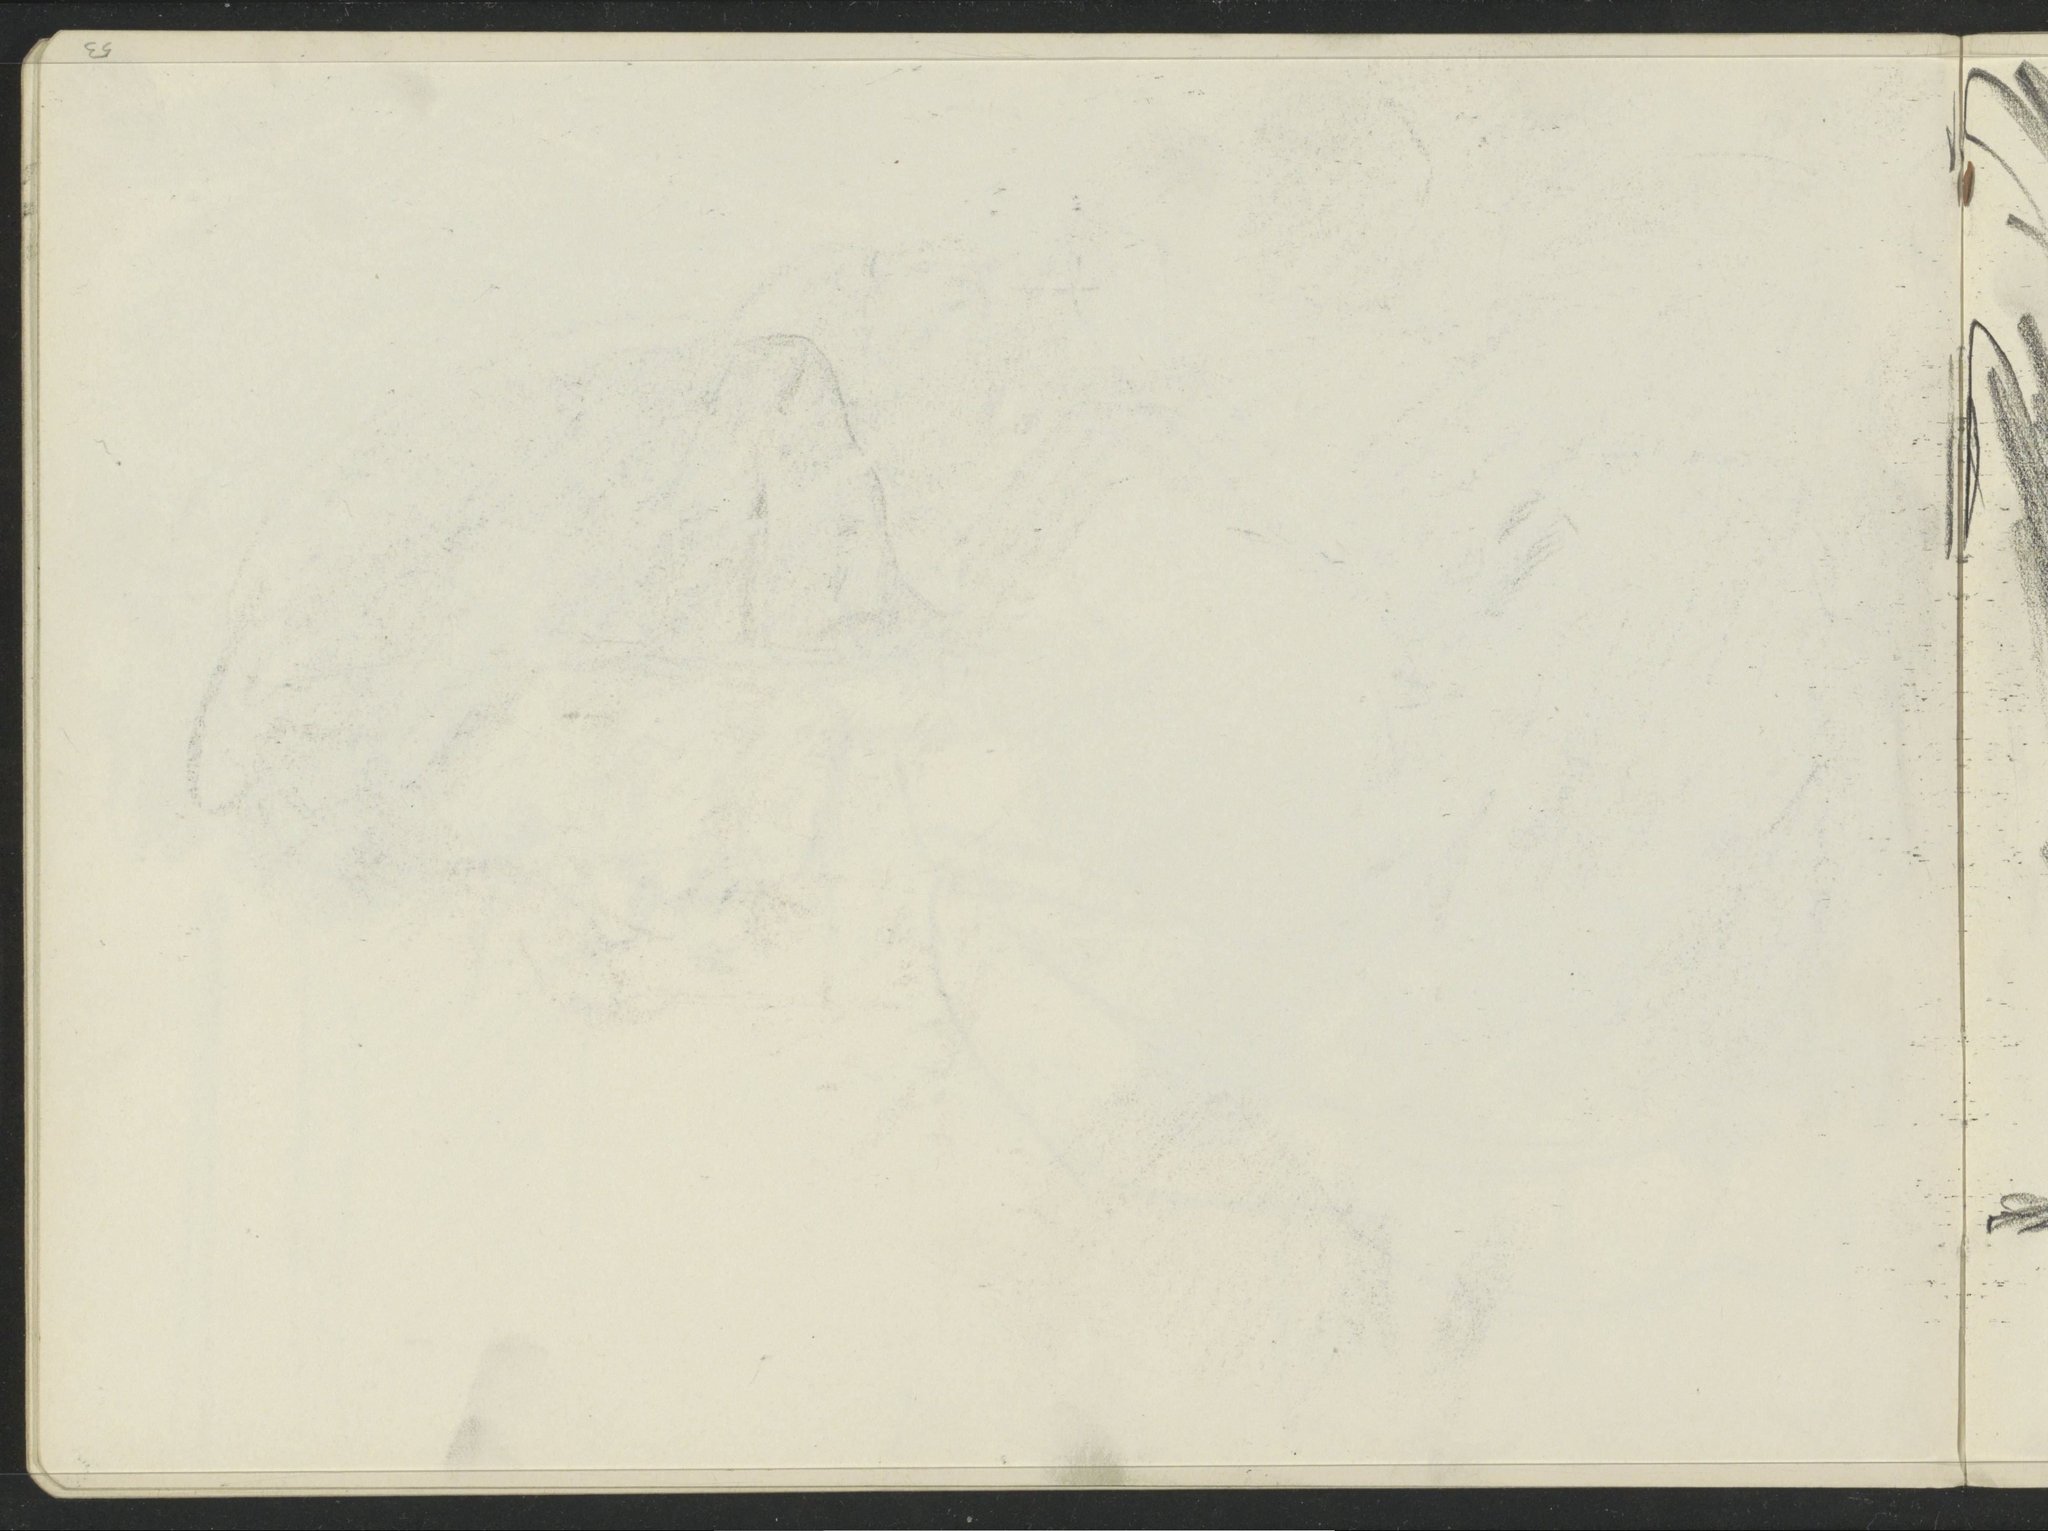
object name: sketchbook leaf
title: Abklatsch van de potloodtekening op blad 13 recto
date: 1915-1934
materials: paper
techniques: printmaking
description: Blad 12 verso uit schetsboek XVI met 32 bladen.